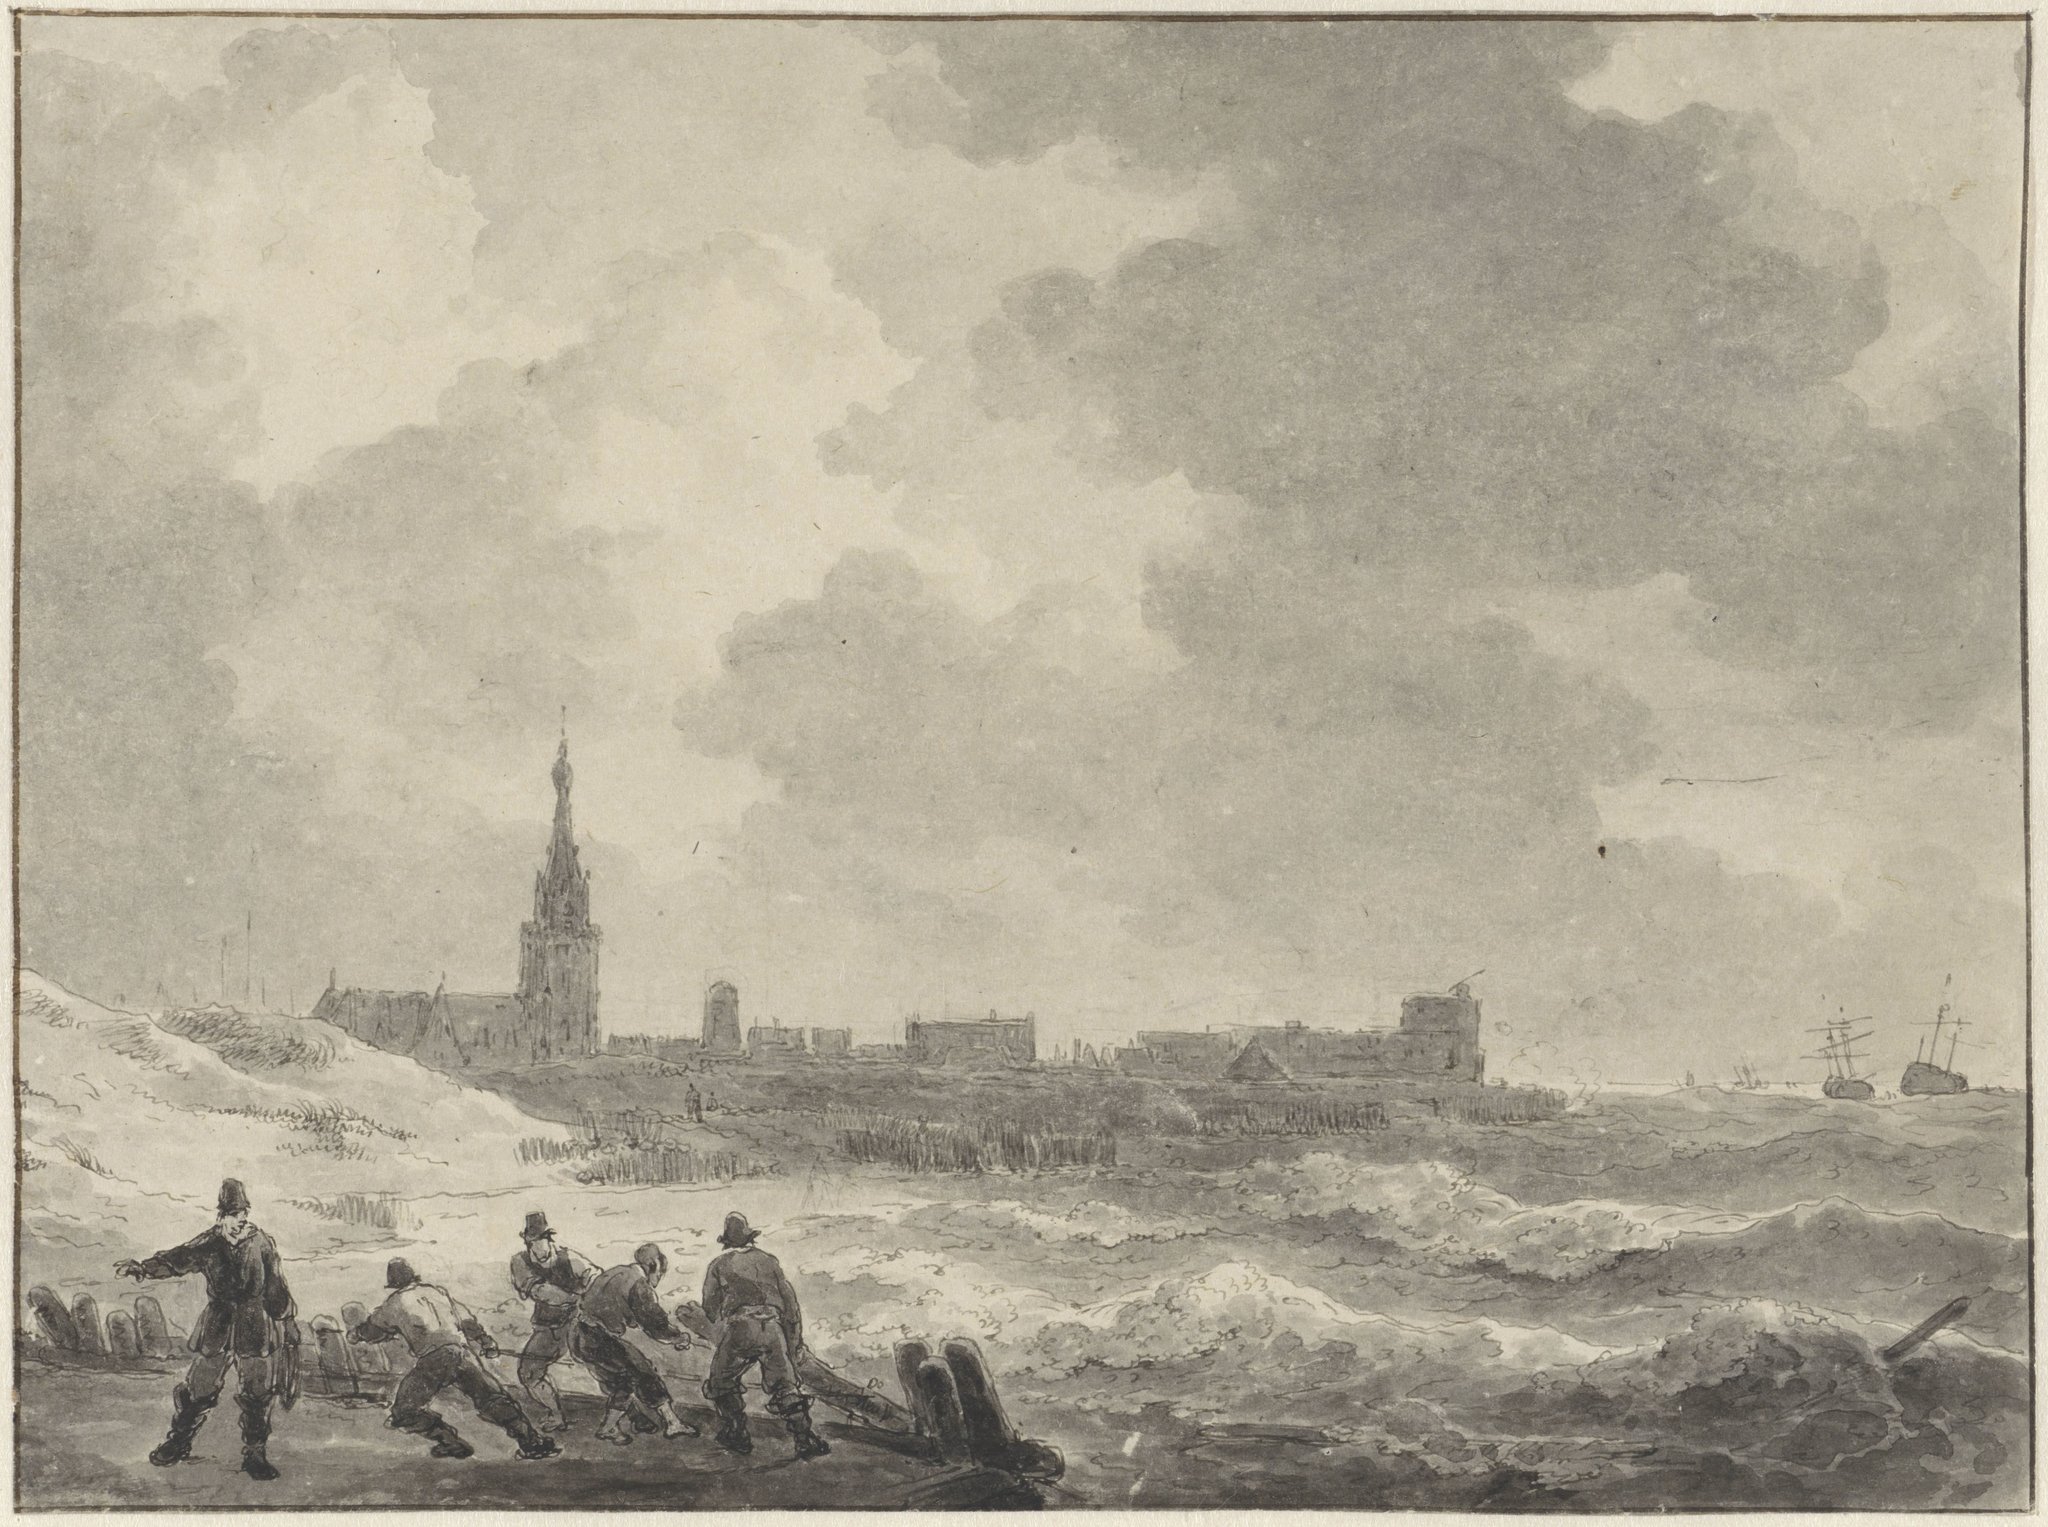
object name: drawing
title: Kust met dorp en kerktoren (Scheveningen?), linksvoor vijf mannen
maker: johannes christiaan schotel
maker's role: draughtsman, painter, print maker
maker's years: 1787-1838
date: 1797-1838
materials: ink, paper, pencil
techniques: brush, pen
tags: village, building of church, coast